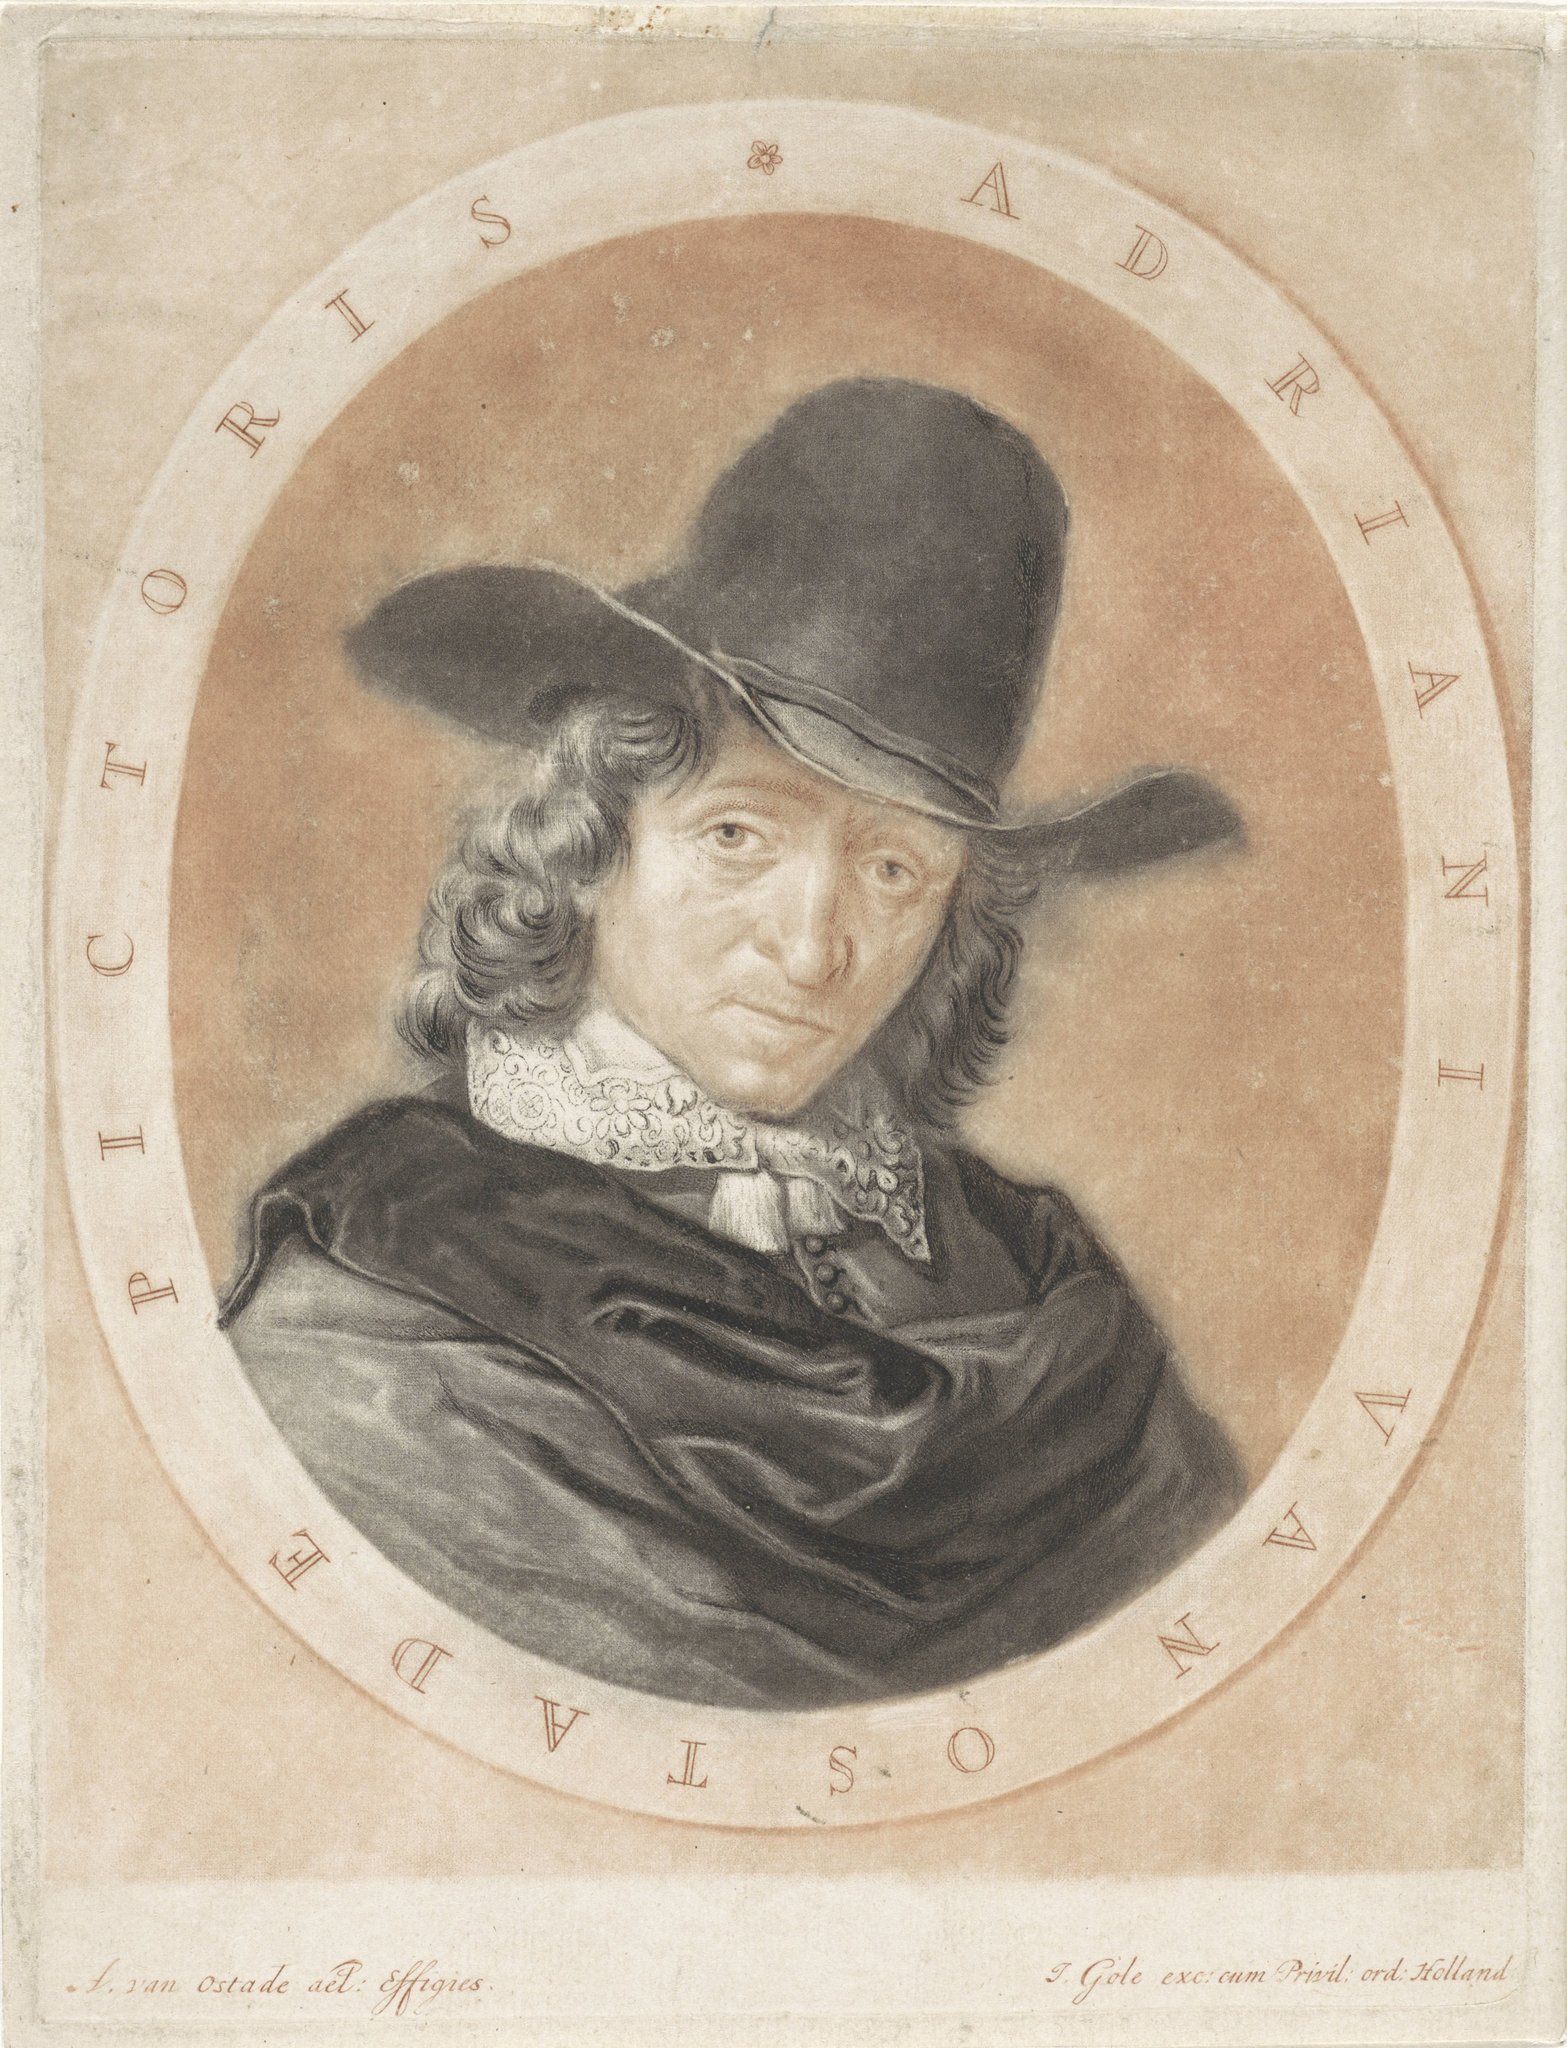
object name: print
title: Portret van Adriaen van Ostade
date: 1670-1724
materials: paper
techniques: etching, lithography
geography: amsterdam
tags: haarlem, print maker, draughtsman, adriaen van ostade, portrait, self-portrait of artist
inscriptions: collector's mark: Lugt 2228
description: De schilder Adriaen van Ostade. Hij heeft zijn hoed schuin op het hoofd.